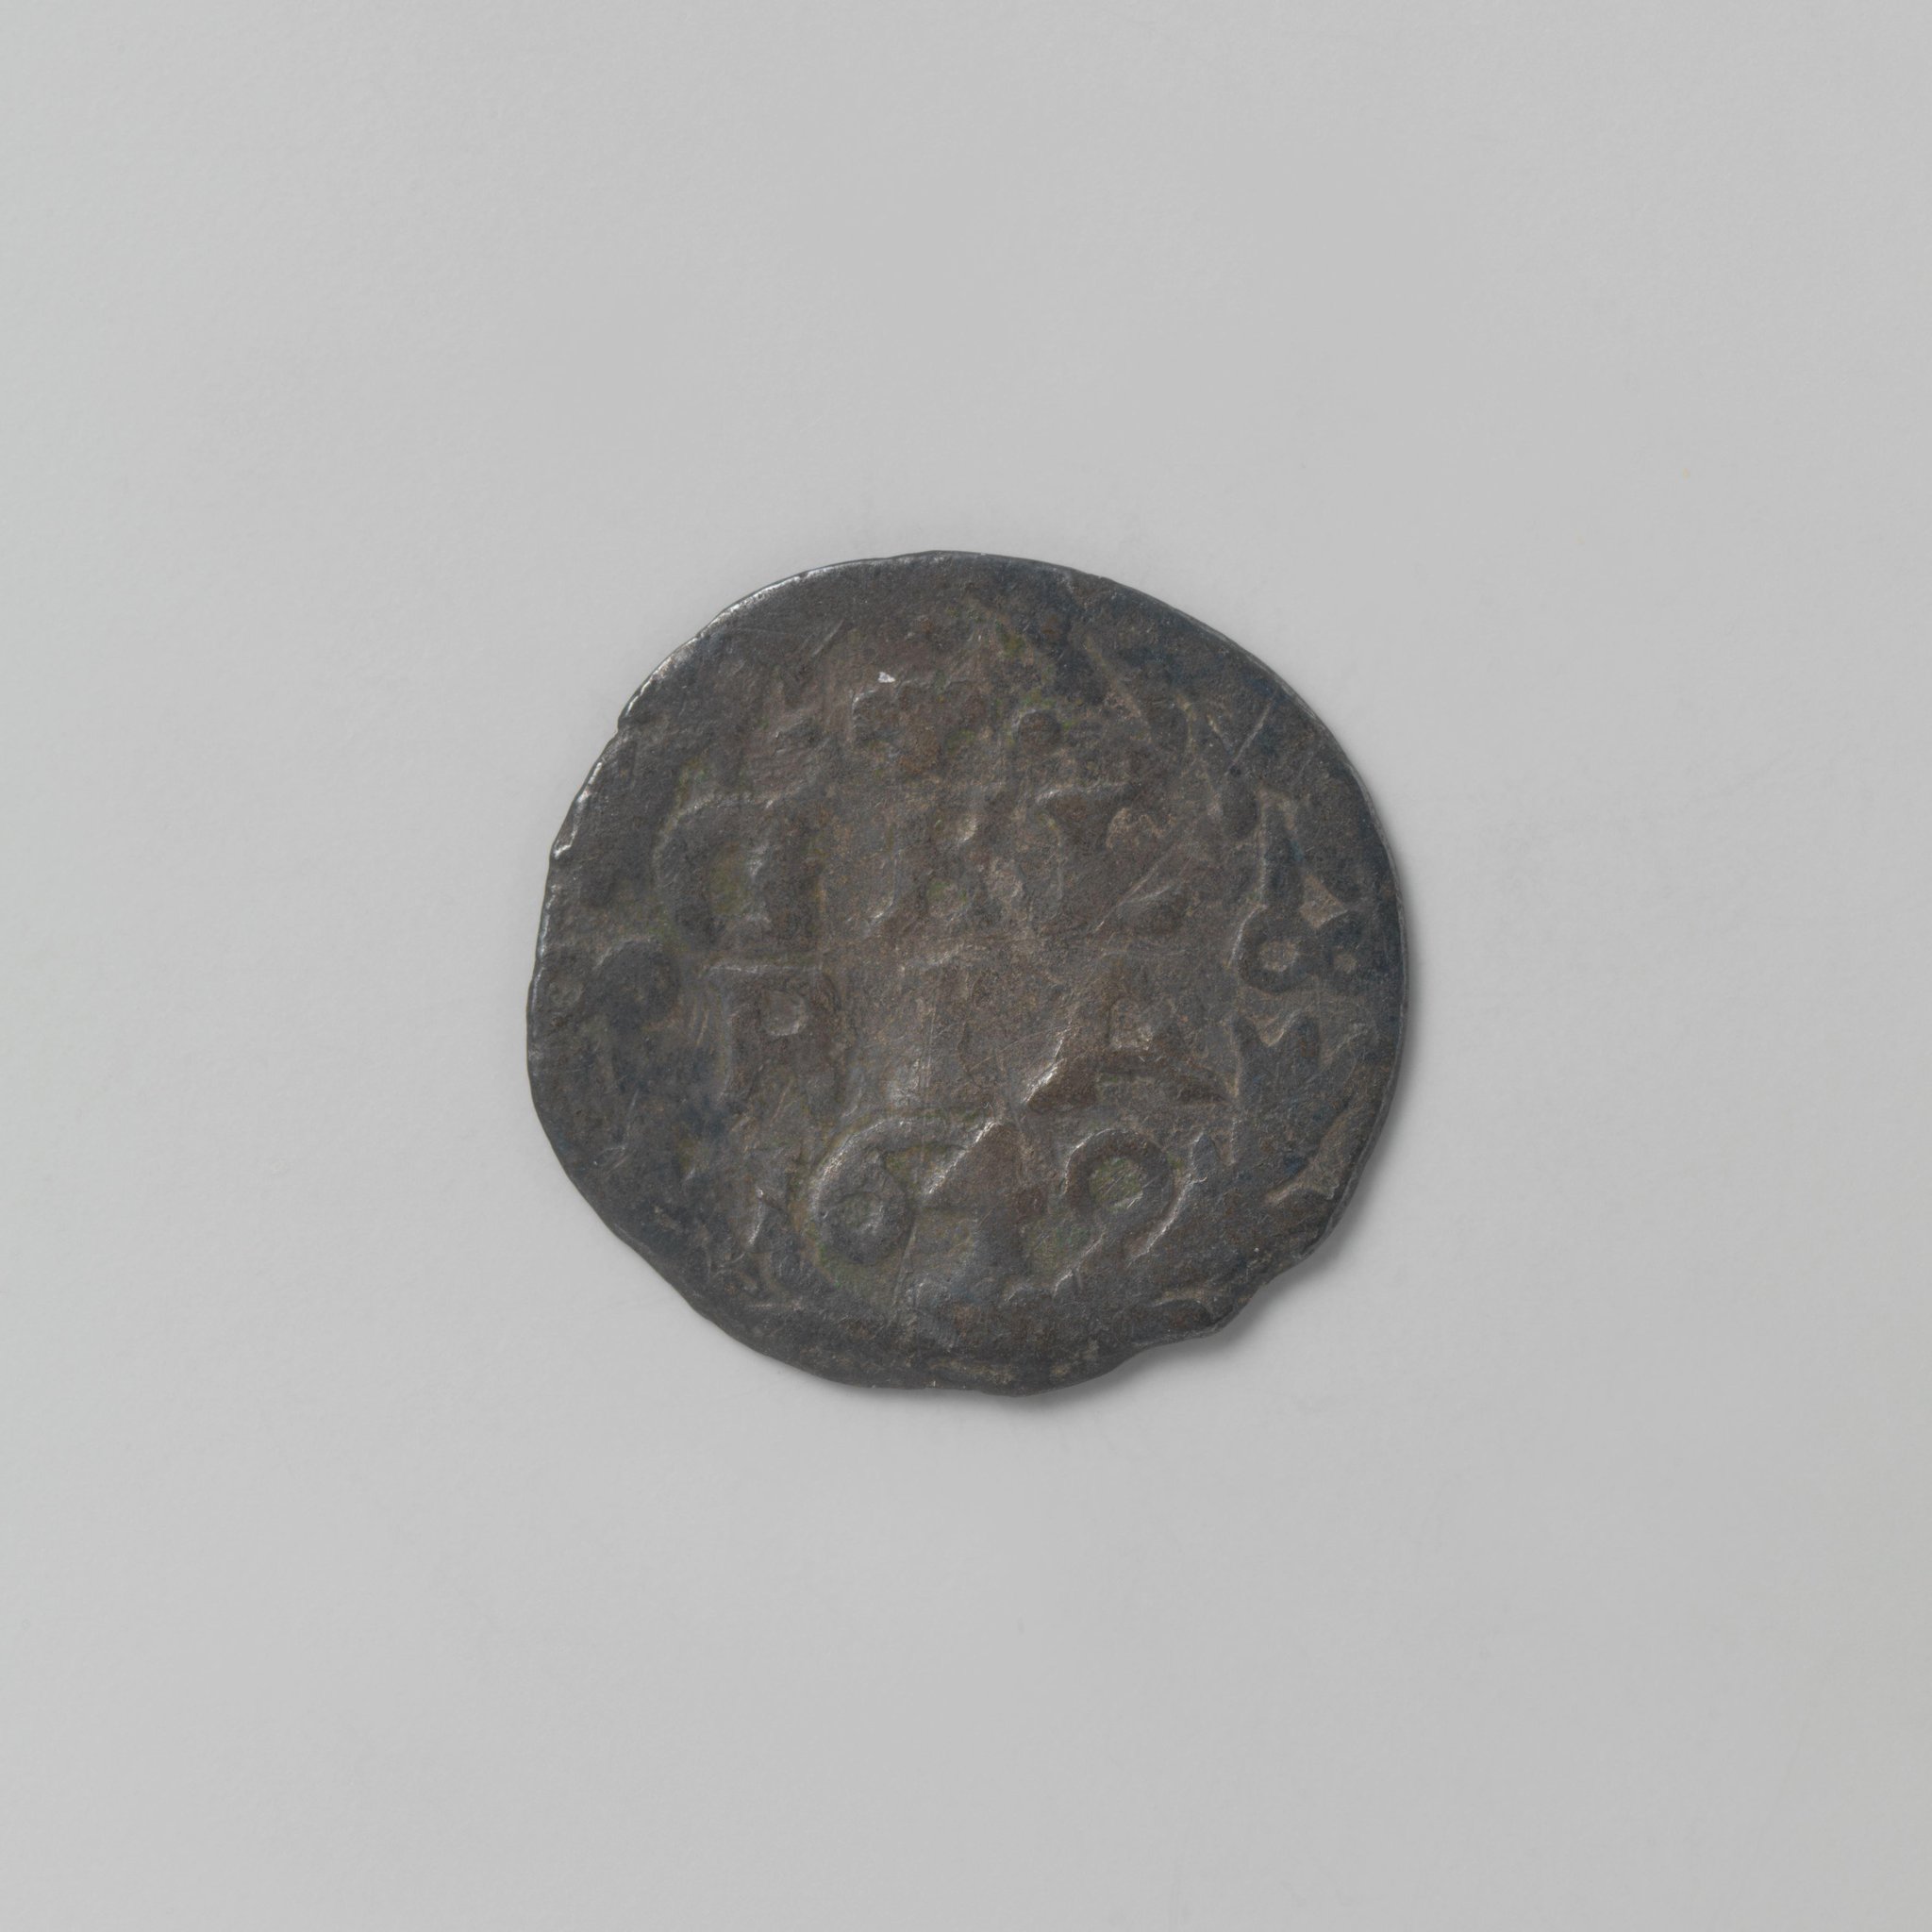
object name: coin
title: Gelderse stuiver, 1640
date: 1640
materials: silver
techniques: striking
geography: harderwijk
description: Zilveren munt. Voorzijde: binnen lauwerkrans in twee regels GEL/RIA, daaronder jaartal, daarboven muntmeesterteken. Keerzijde: binnen lauwerkrans tussen waarde-aanduiding pijlenbundel.